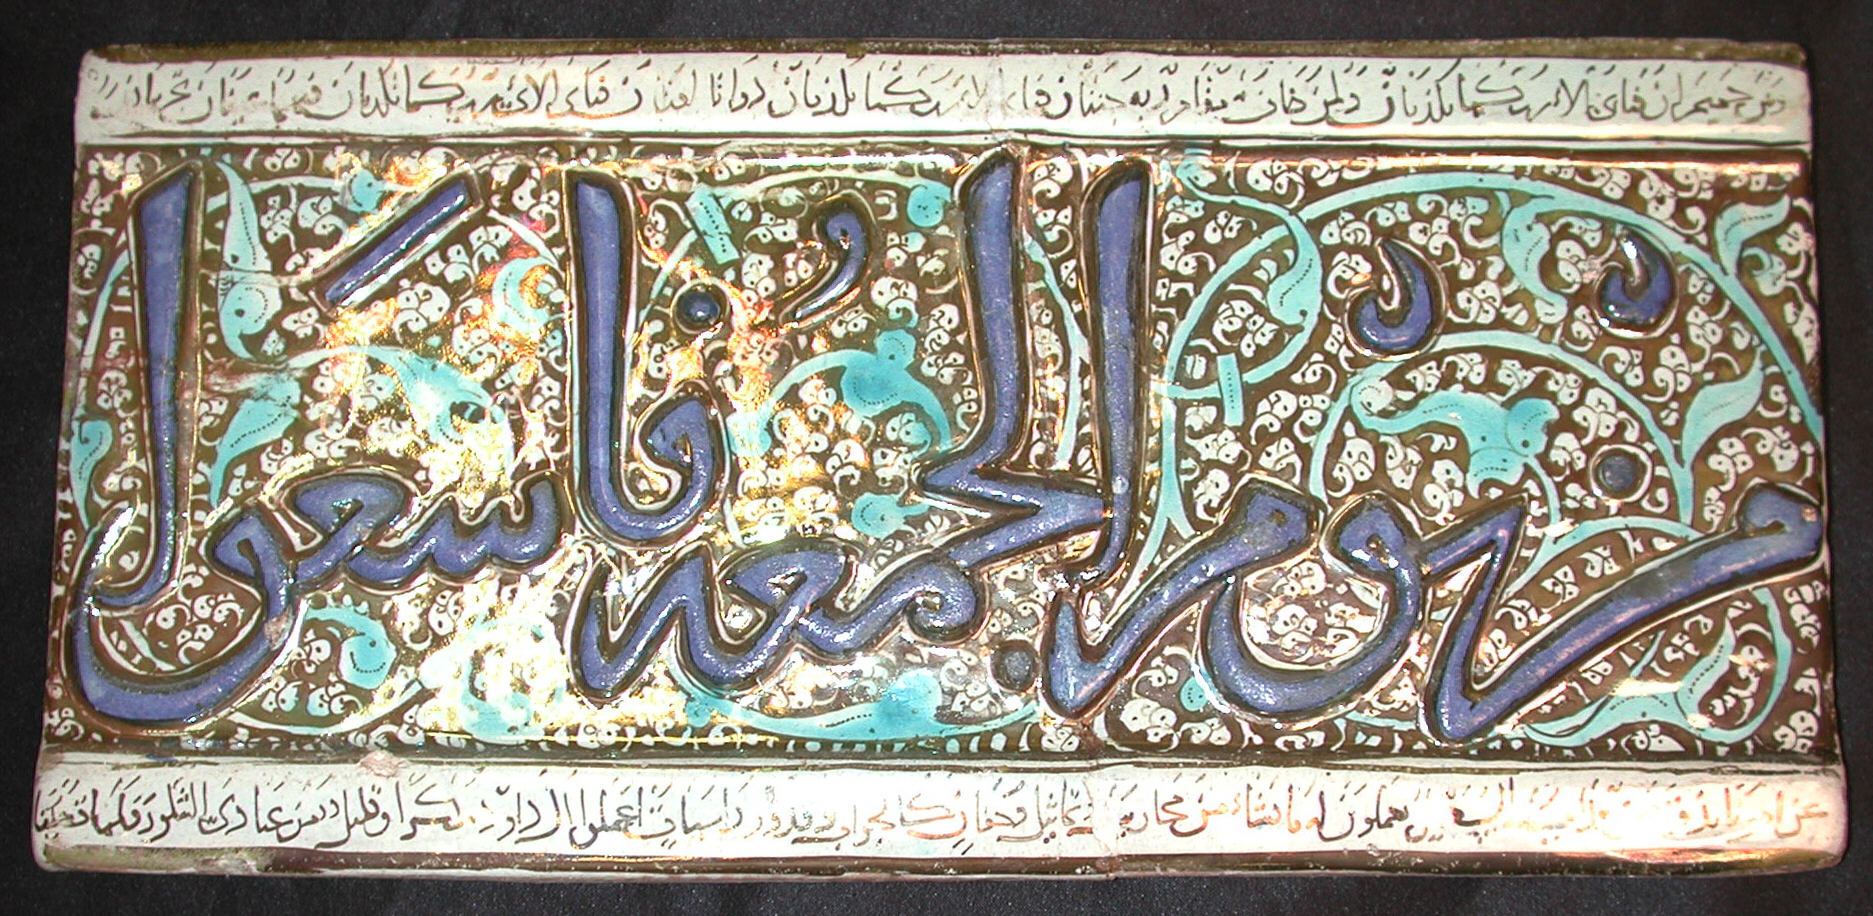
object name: tile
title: Tile from a Frieze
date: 1201-1300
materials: glaze, stonepaste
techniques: luster painting, painting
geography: iran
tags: arabic,calligraphy